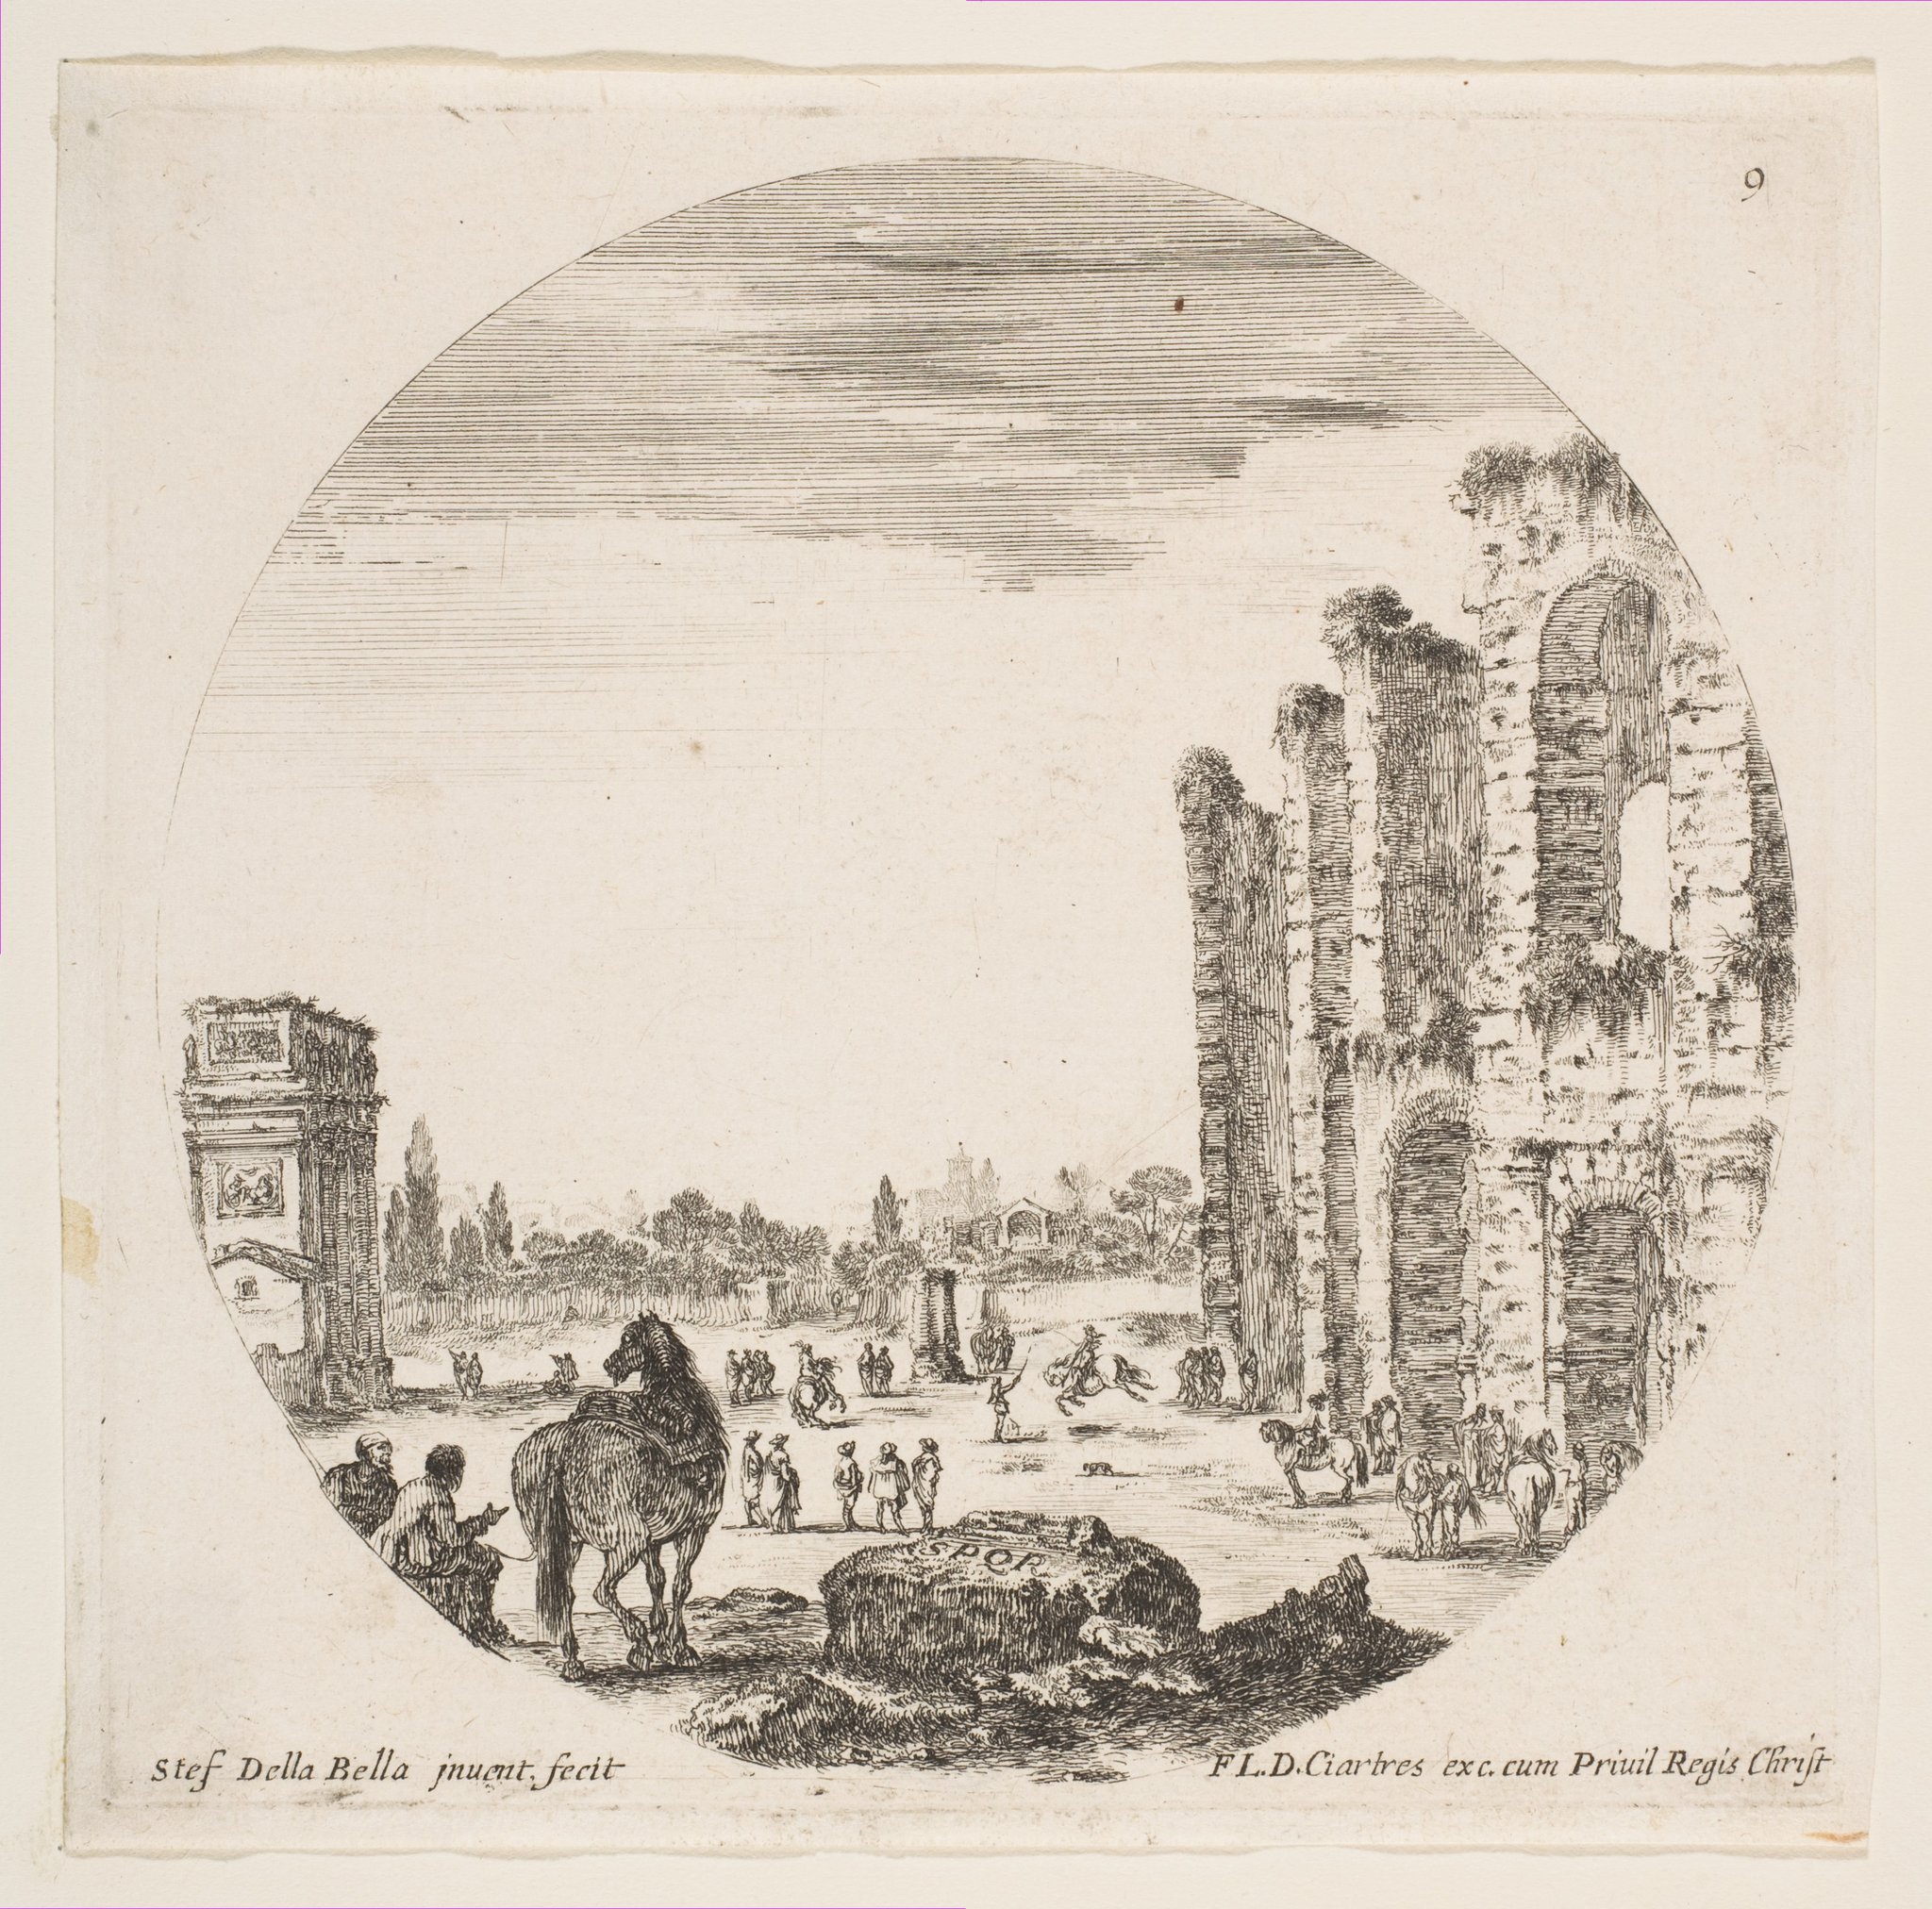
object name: print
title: The Arch of Constantine at left, part of the Colosseum at right, various horses and figures in foreground and background, plate 9 from "Roman landscapes and ruins" (Paysages et ruines de Rome)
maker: stefano della bella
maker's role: artist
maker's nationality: italian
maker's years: 1610-1664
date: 1646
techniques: etching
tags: arches,ruins,horses,rome